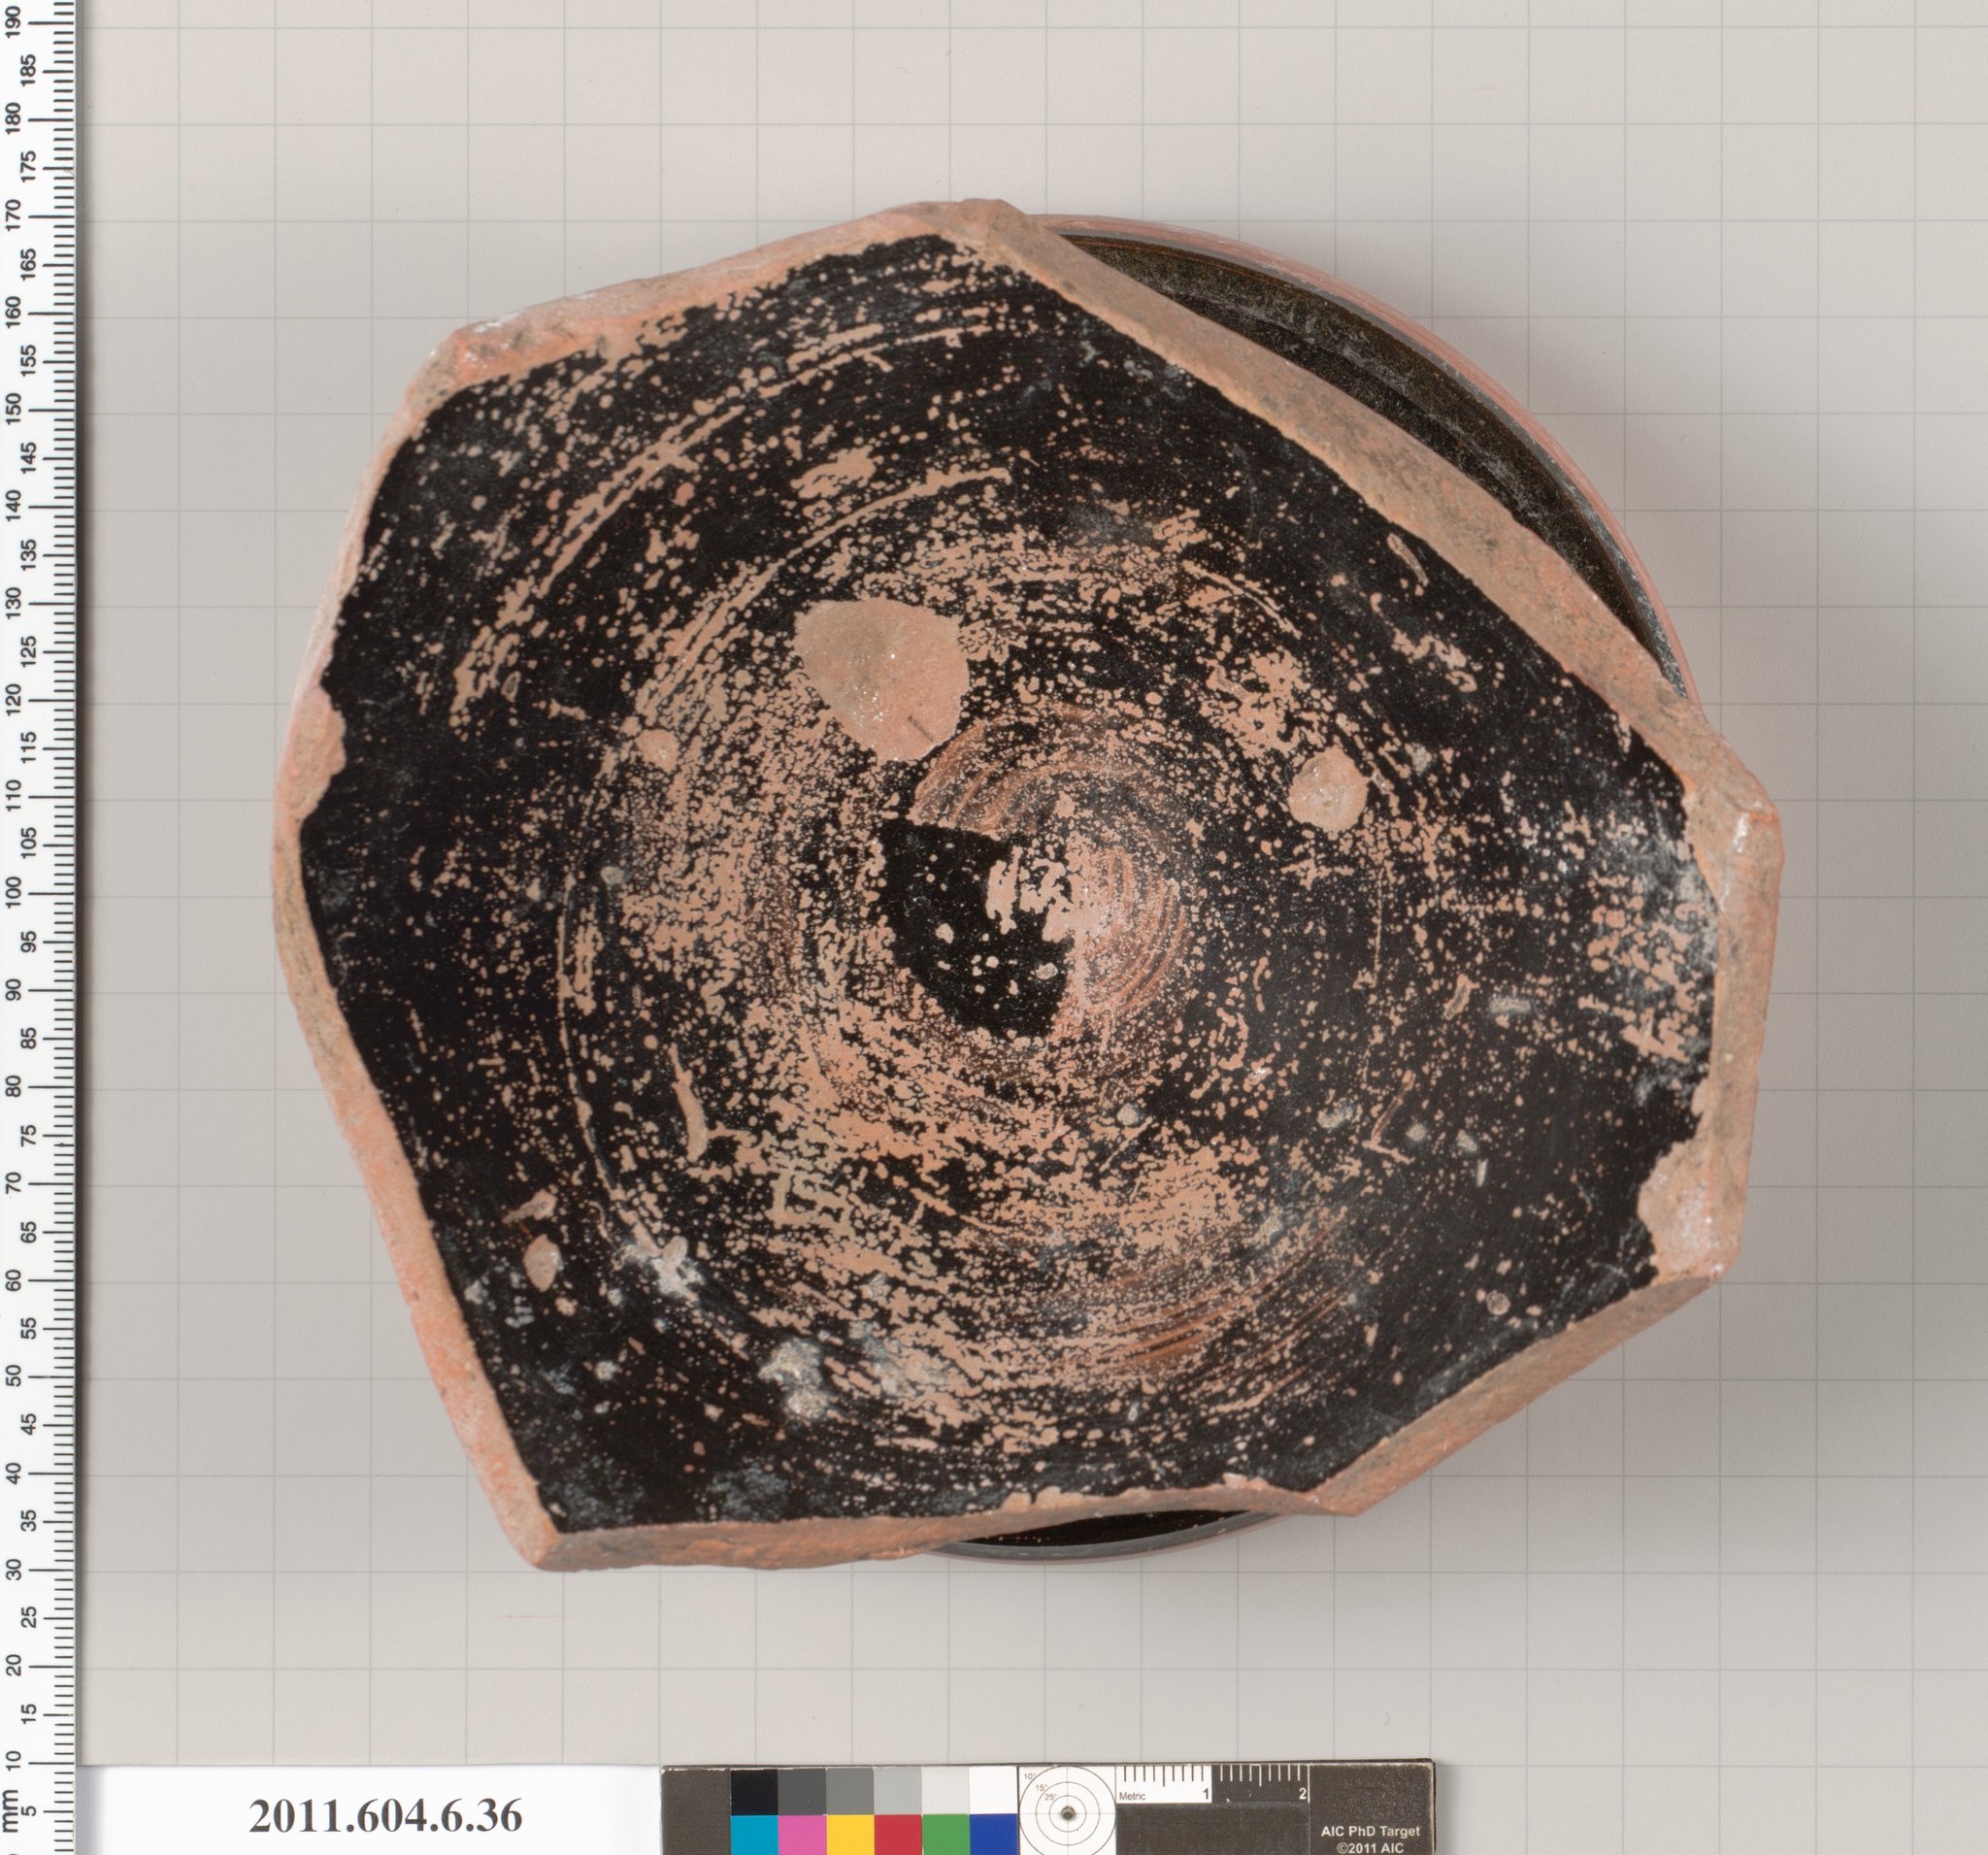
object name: krater fragment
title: Terracotta fragment of a krater (bowl for mixing wine and water)?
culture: greek, attic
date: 500-401 BCE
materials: terracotta